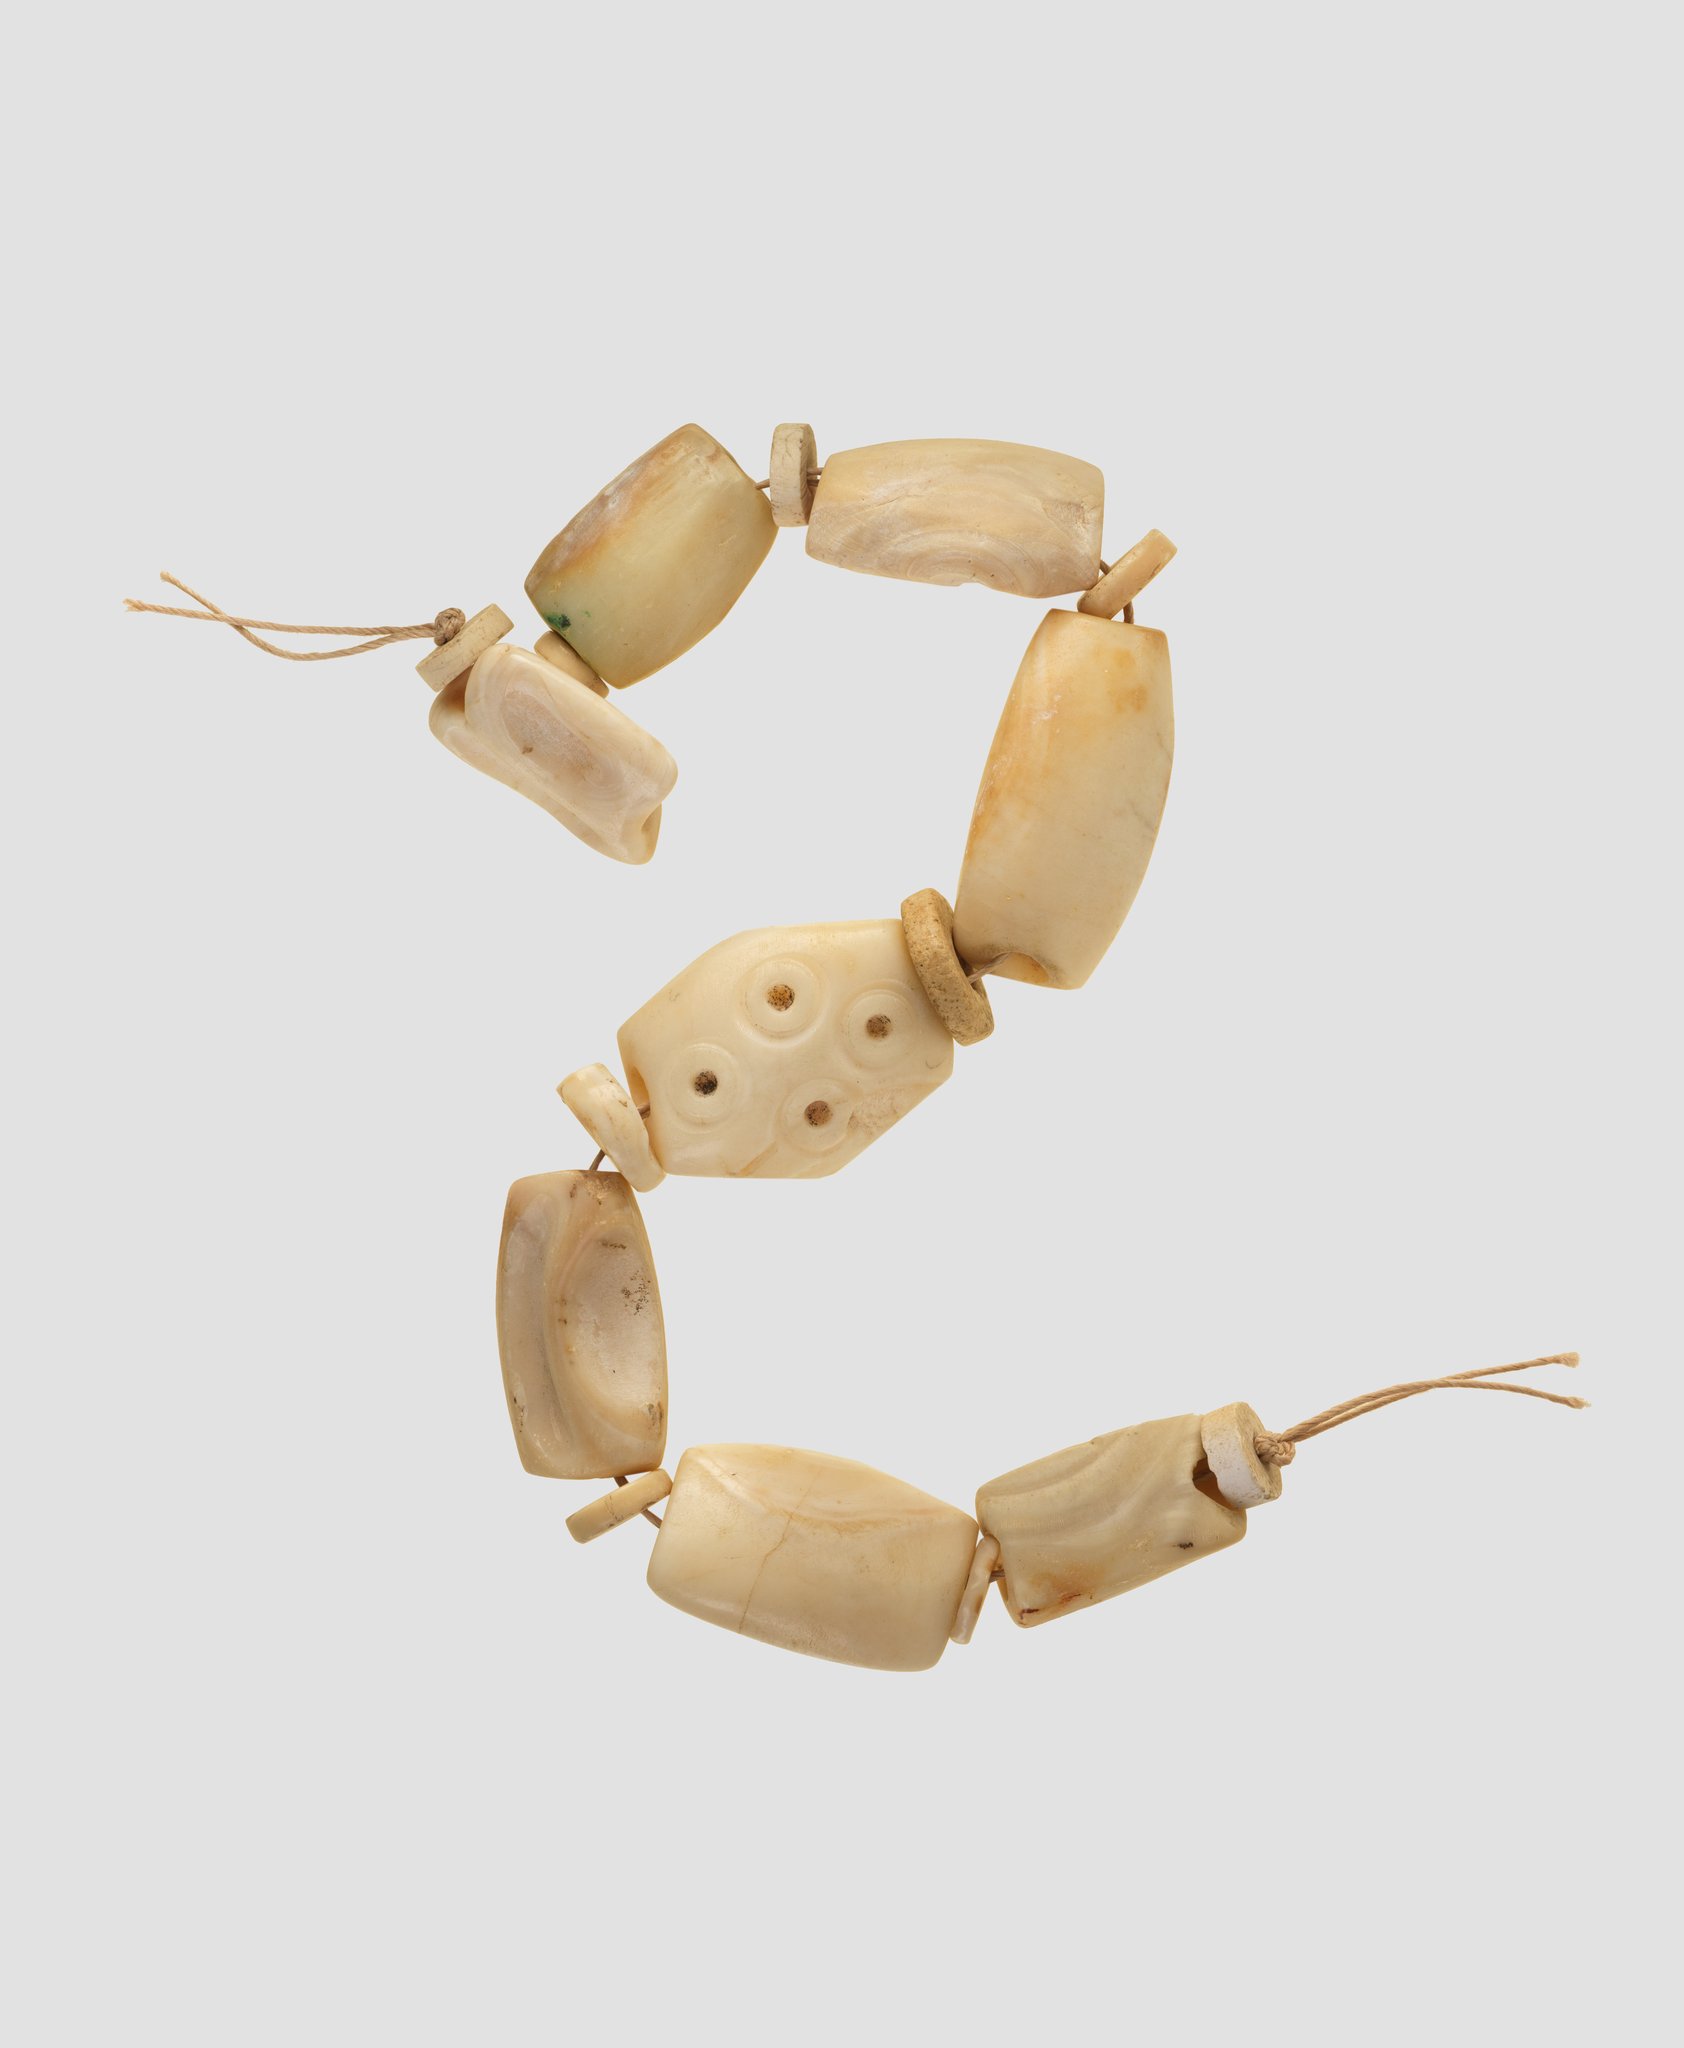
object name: bead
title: Beads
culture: iranian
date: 900-801 BCE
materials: shell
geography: iran